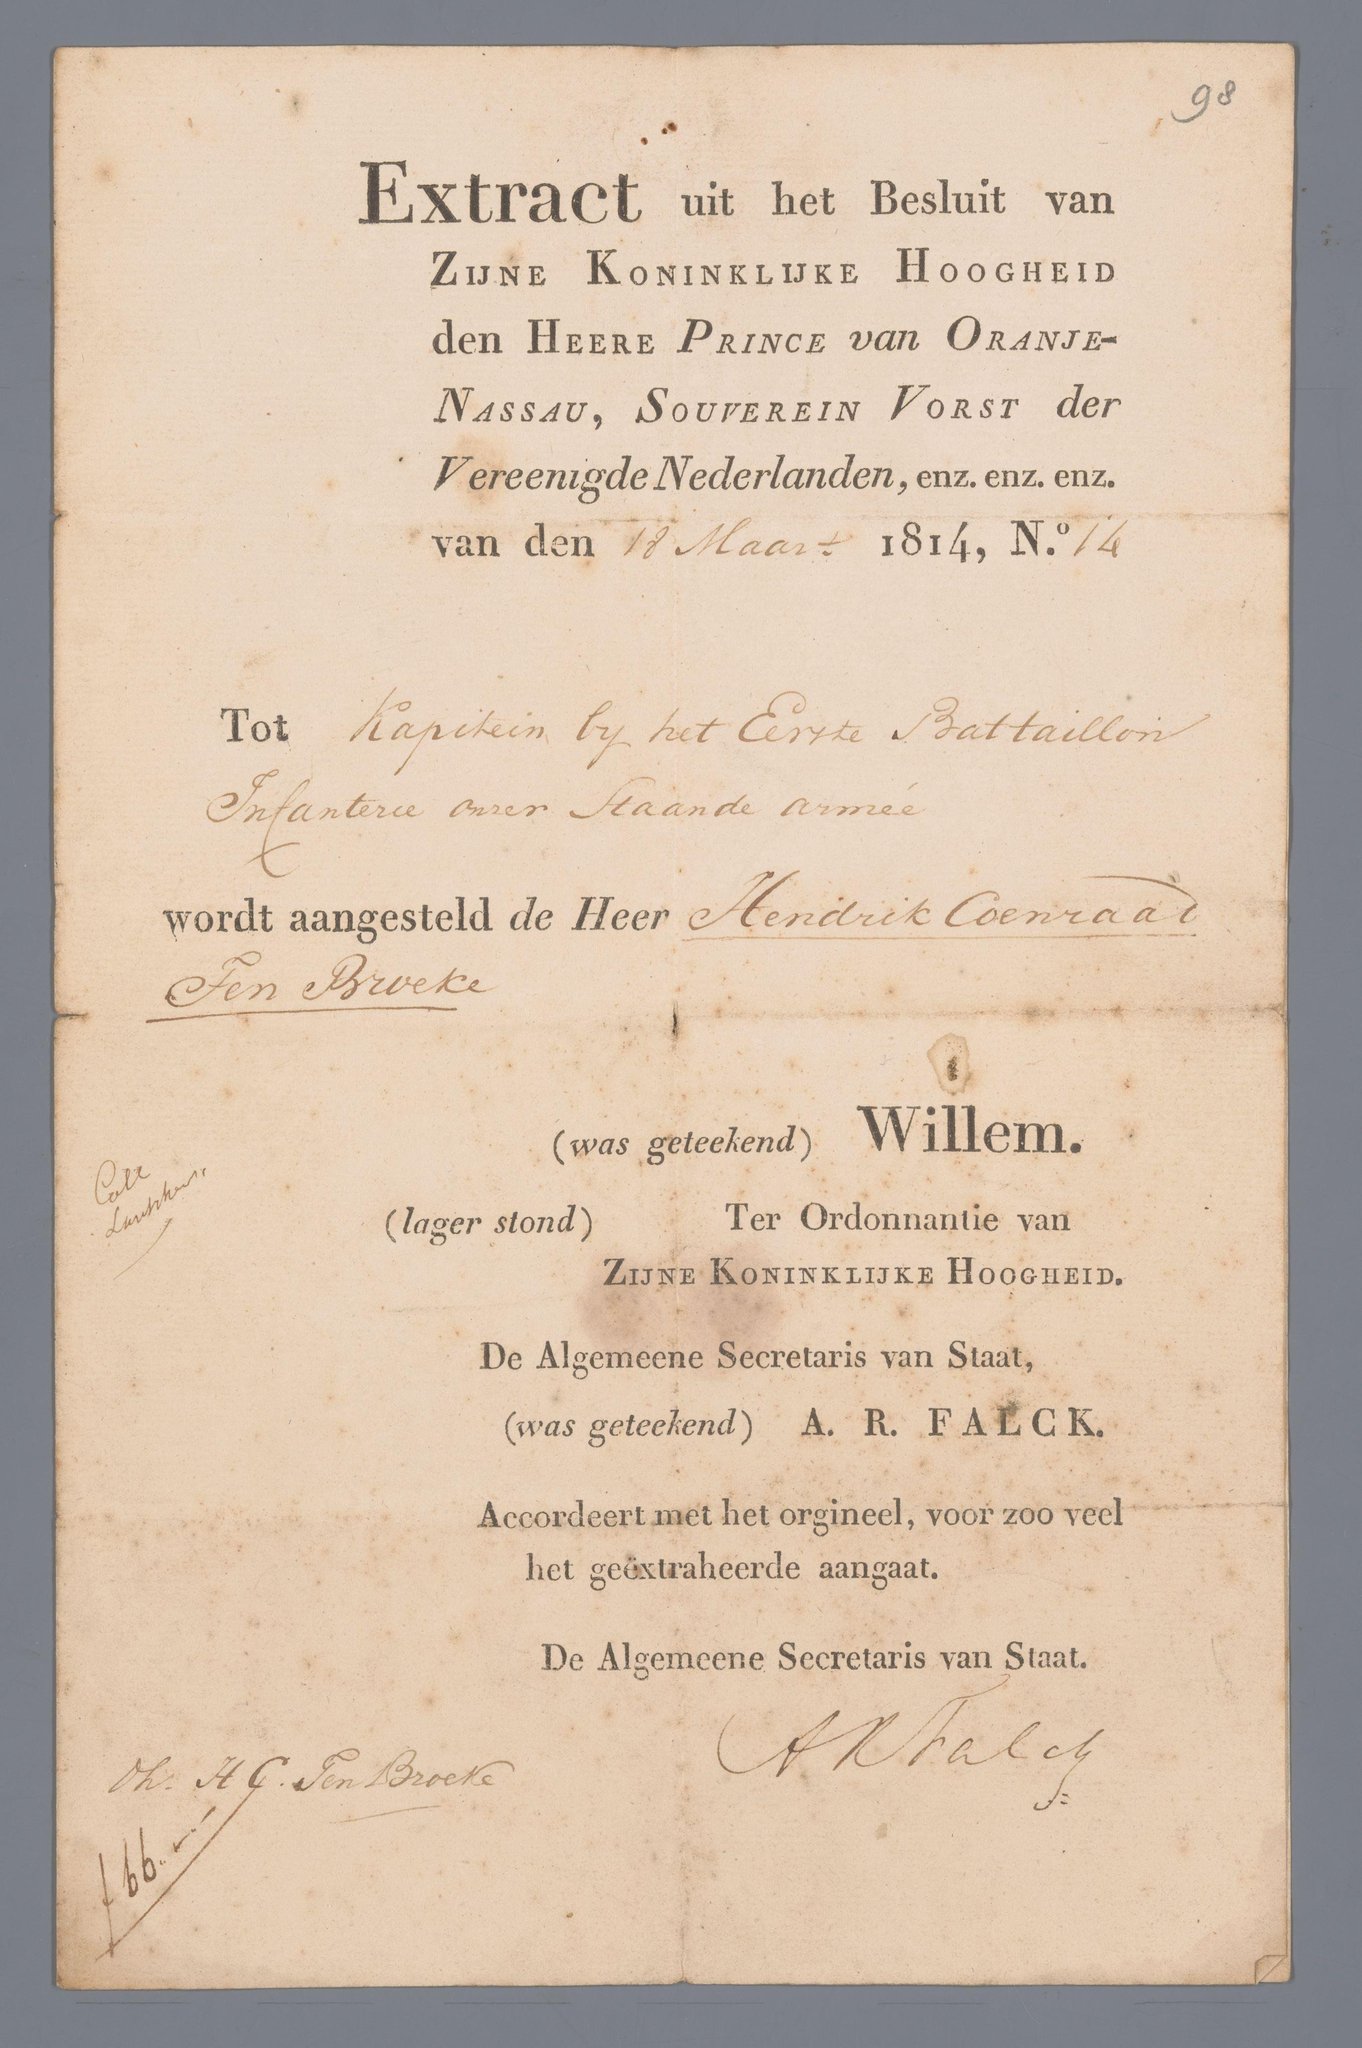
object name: document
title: Extract uit het Besluit van Zijne Koninklijke Hoogheid den Heere Prince van Oranje-Nassau, Souverein Vorst der Vereenigde Nederlanden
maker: anton reinhard falck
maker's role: minister van koloniën, minister van nijverheid, minister van onderwijs, advocaat, secretaris-generaal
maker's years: 1777-1843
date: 1814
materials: ink, paper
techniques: printing, writing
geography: the hague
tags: utrecht, brussels, anton reinhard falck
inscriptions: date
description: Dubbelgevouwen blad papier, voorzijde bedrukt en beschreven, document waarbij H. C. Ten broeke tot Kapitein 1e Bataillon Infanterie wordt benoemd. Gesigneerd en gedateerd.